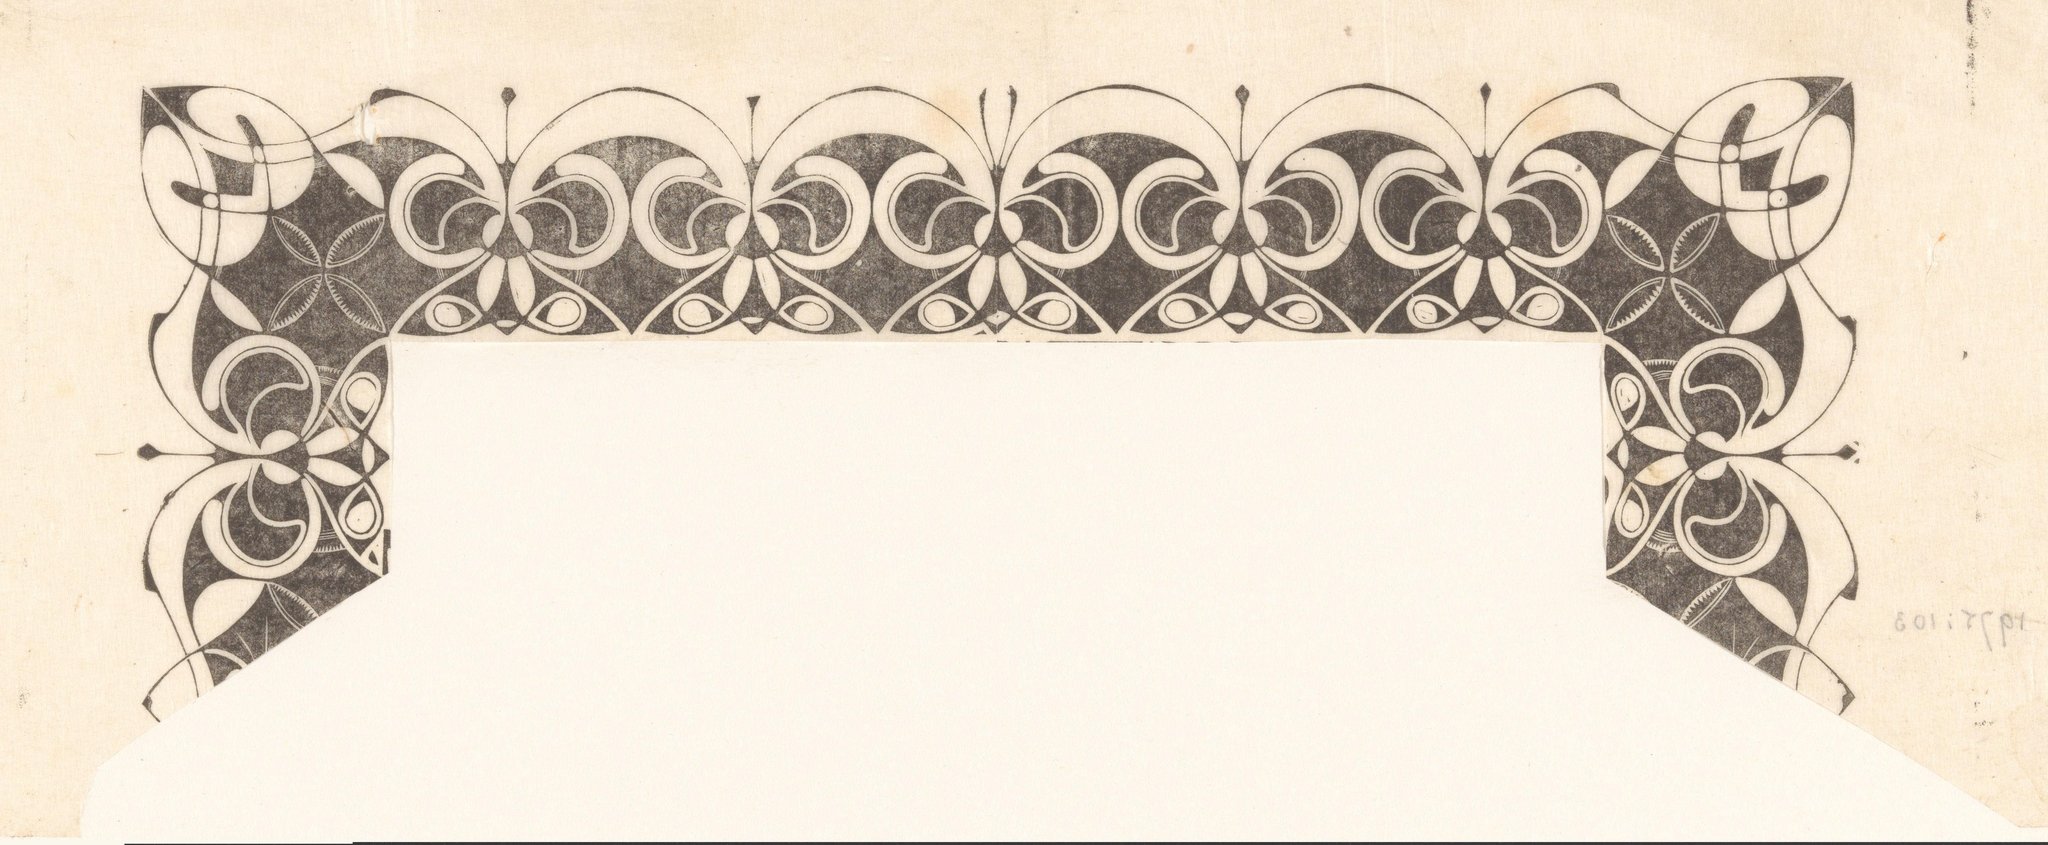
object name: vignette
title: Omlijsting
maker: karel petrus cornelis de bazel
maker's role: draughtsman, print maker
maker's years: 1869-1923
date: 1879-1923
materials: paper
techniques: woodcut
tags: vignette